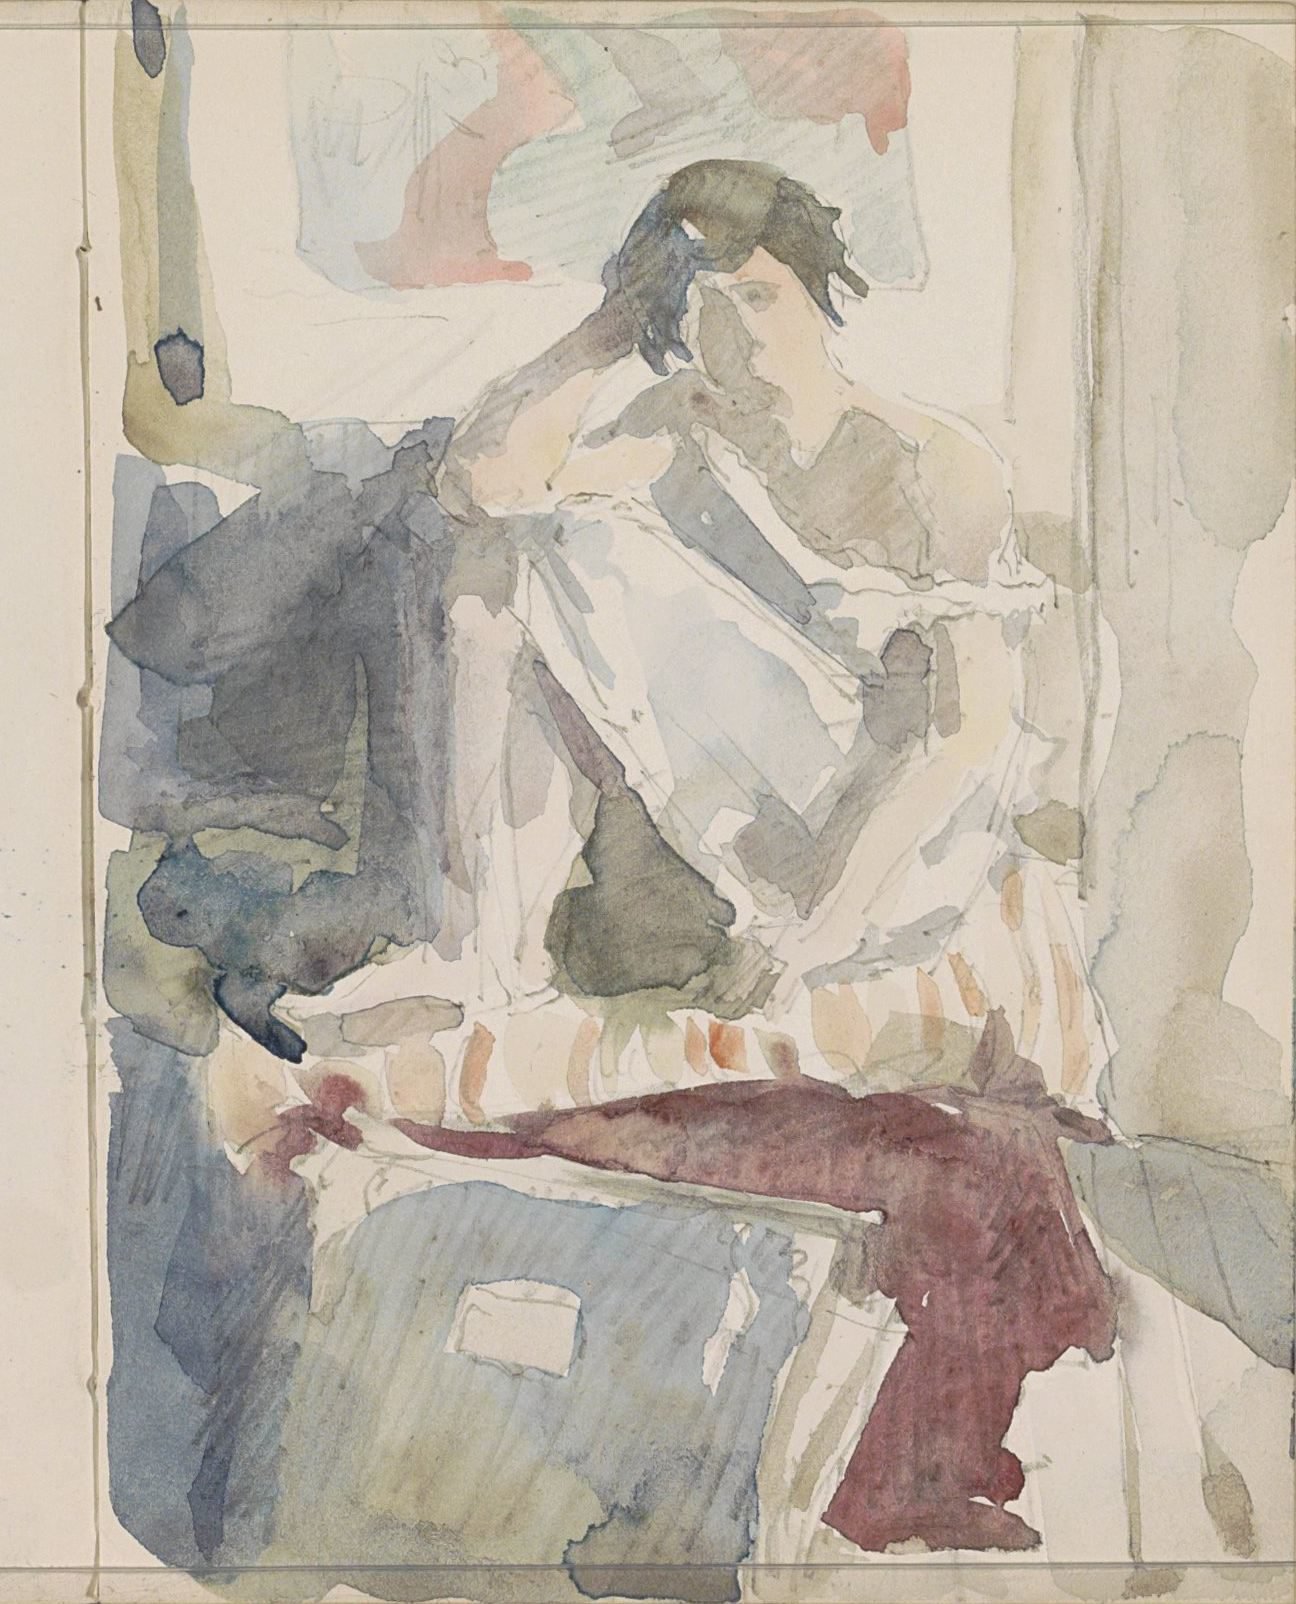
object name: sketchbook leaf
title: Zittende vrouw in een interieur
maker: reijer stolk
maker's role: draughtsman, print maker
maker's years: 1896-1945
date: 1916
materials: paper, pencil, watercolor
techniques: brush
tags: sitting figure - aa - female human figure, interior of the house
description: De vrouw draagt een nachtjapon en zit met één been opgetrokken, haar elleboog steunend op de knie. Op de voorgrond staat een map, mogelijk een tekenmap. Blad 63 recto uit een schetsboek met 72 bladen.